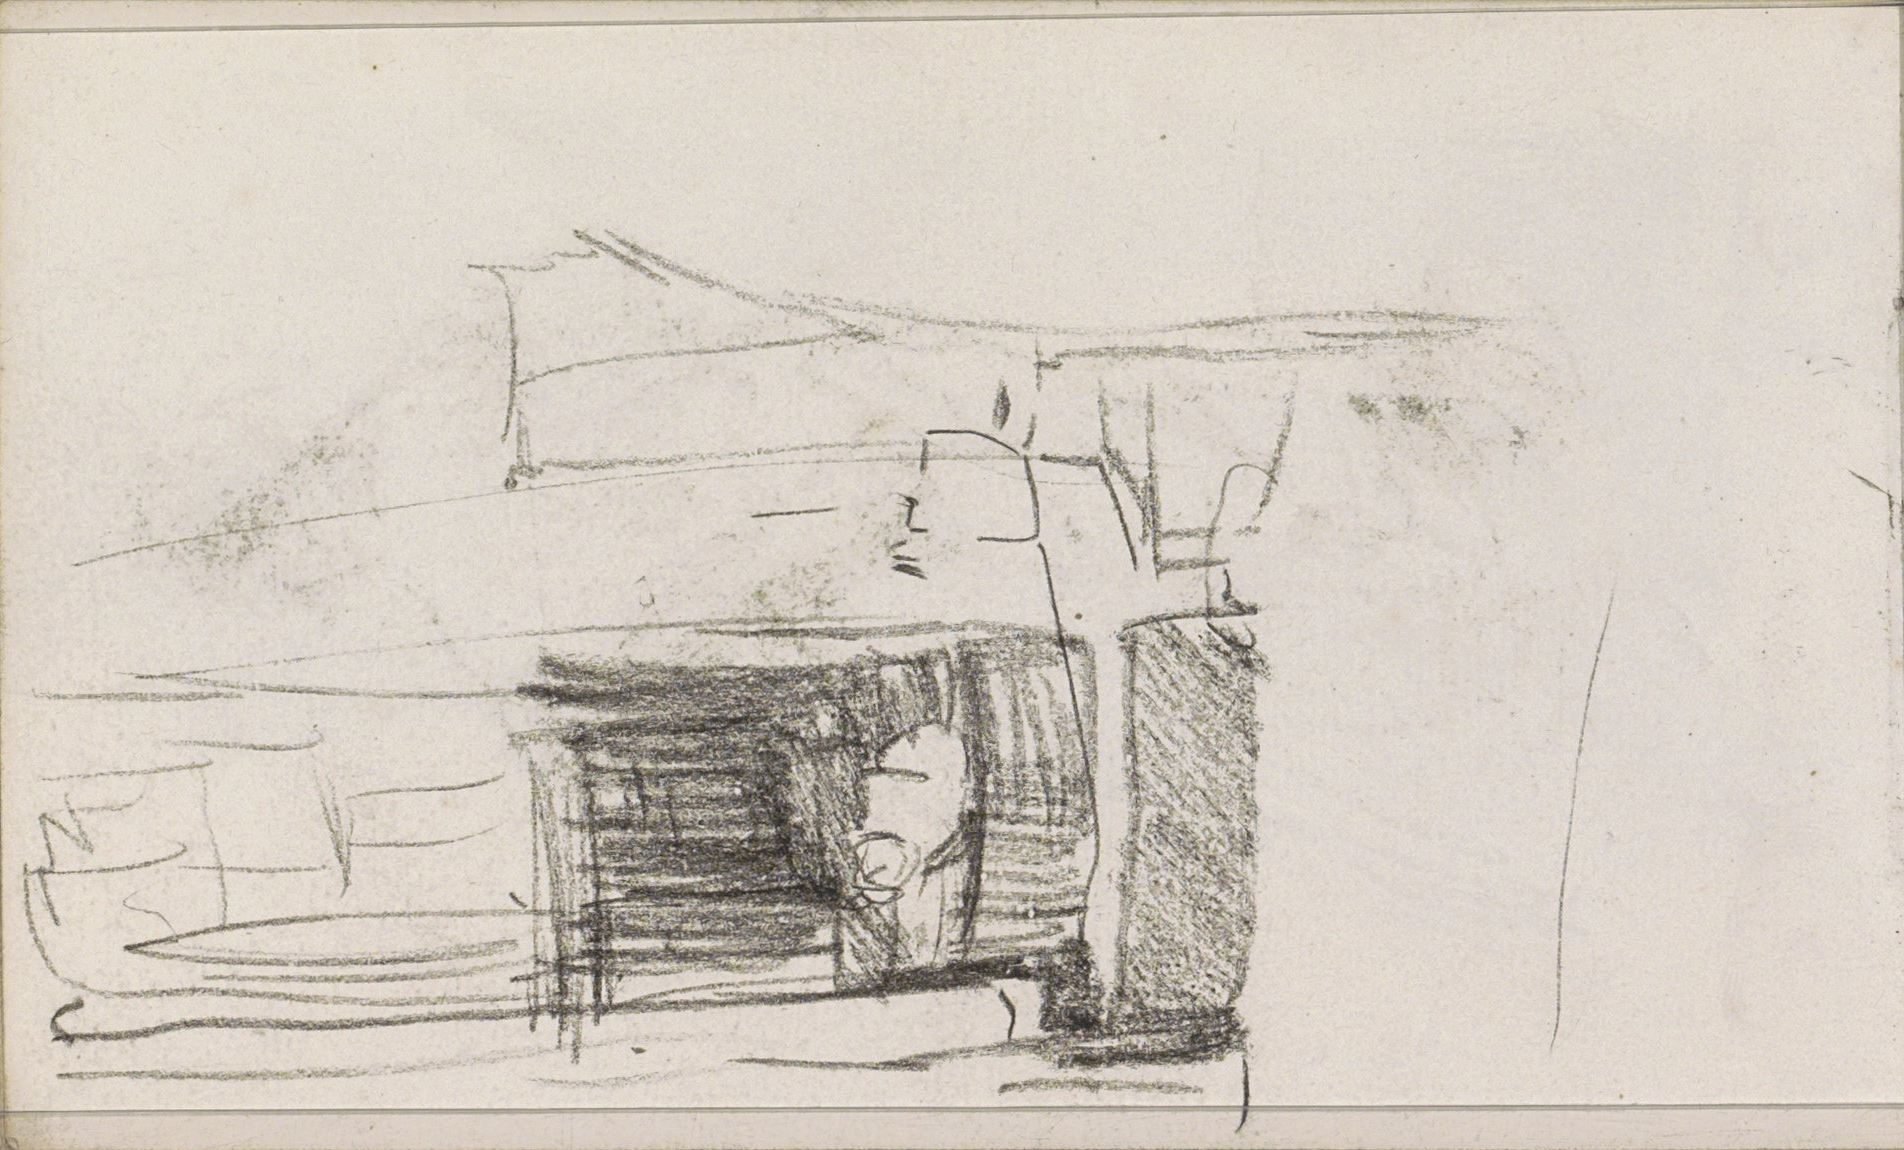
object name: sketchbook leaf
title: Studie, mogelijk een kat op de trap voor een deur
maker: isaac israels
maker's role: draughtsman, painter, print maker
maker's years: 1865-1934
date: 1875-1934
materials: chalk, paper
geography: the hague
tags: cat, door, front steps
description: Pagina 48 uit schetsboek XLVIII met 62 pagina's.